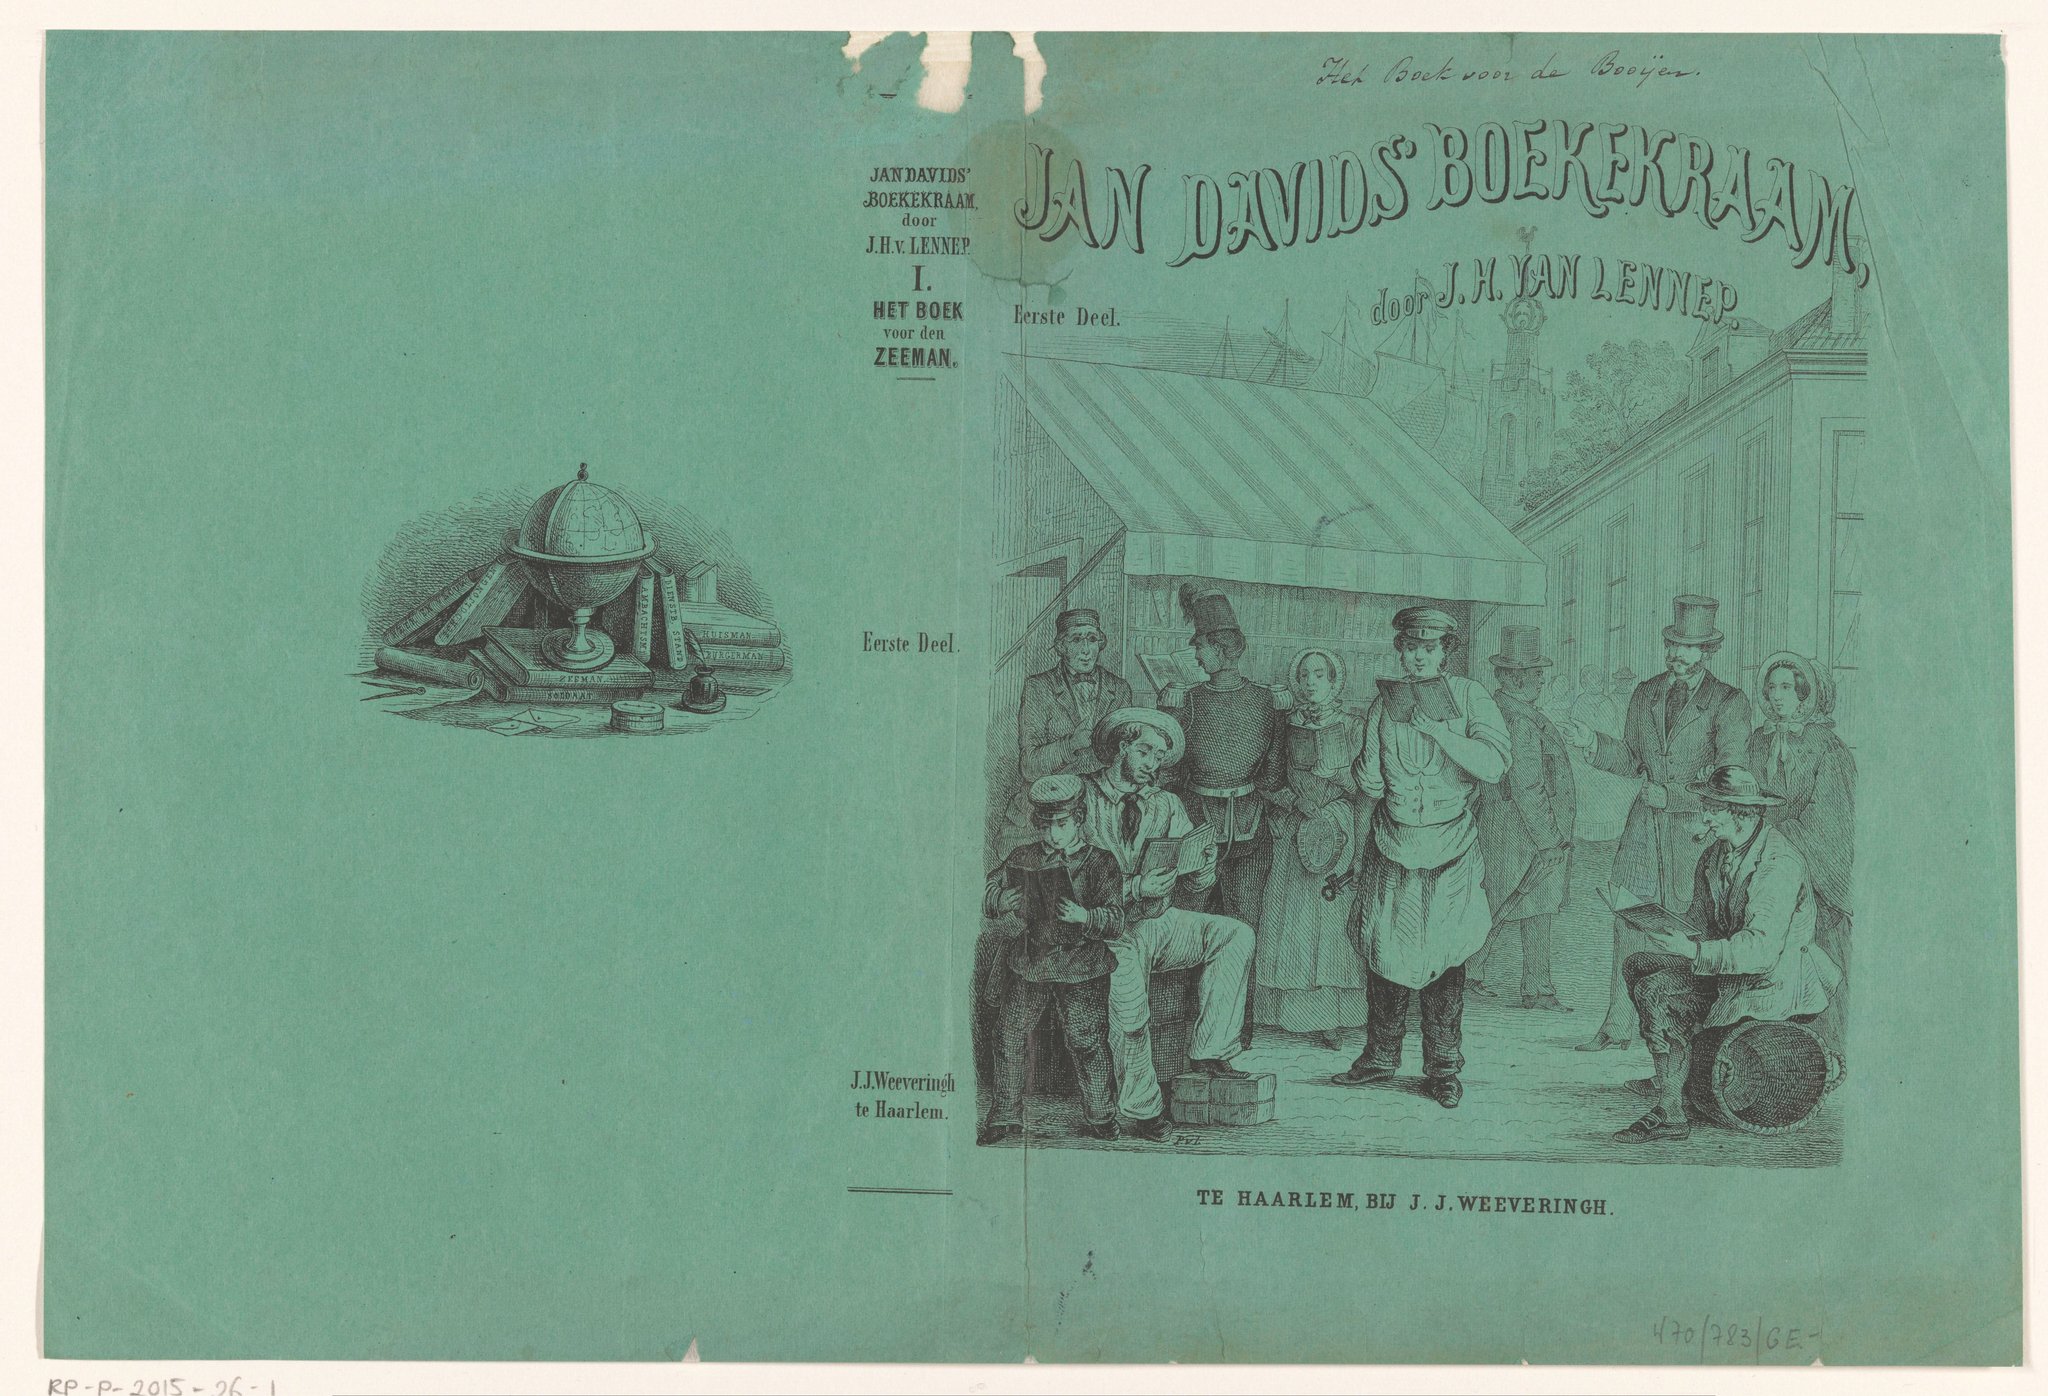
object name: print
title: Lezende figuren bij een boekenkraam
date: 1860-1862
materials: paper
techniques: engraving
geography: haarlem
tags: book-stall, kiosk, reading, globe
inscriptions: collector's mark: Lugt 2228, annotation: ‘Het Boek voor de Booijen’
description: Op de voorzijde staande en zittende figuren bij een boekenkraam. Op de achtergrond een of meerdere zeilschepen en een kerktoren. Op de achterzijde van het omslag boeken en schrijfgerei rond een globe.